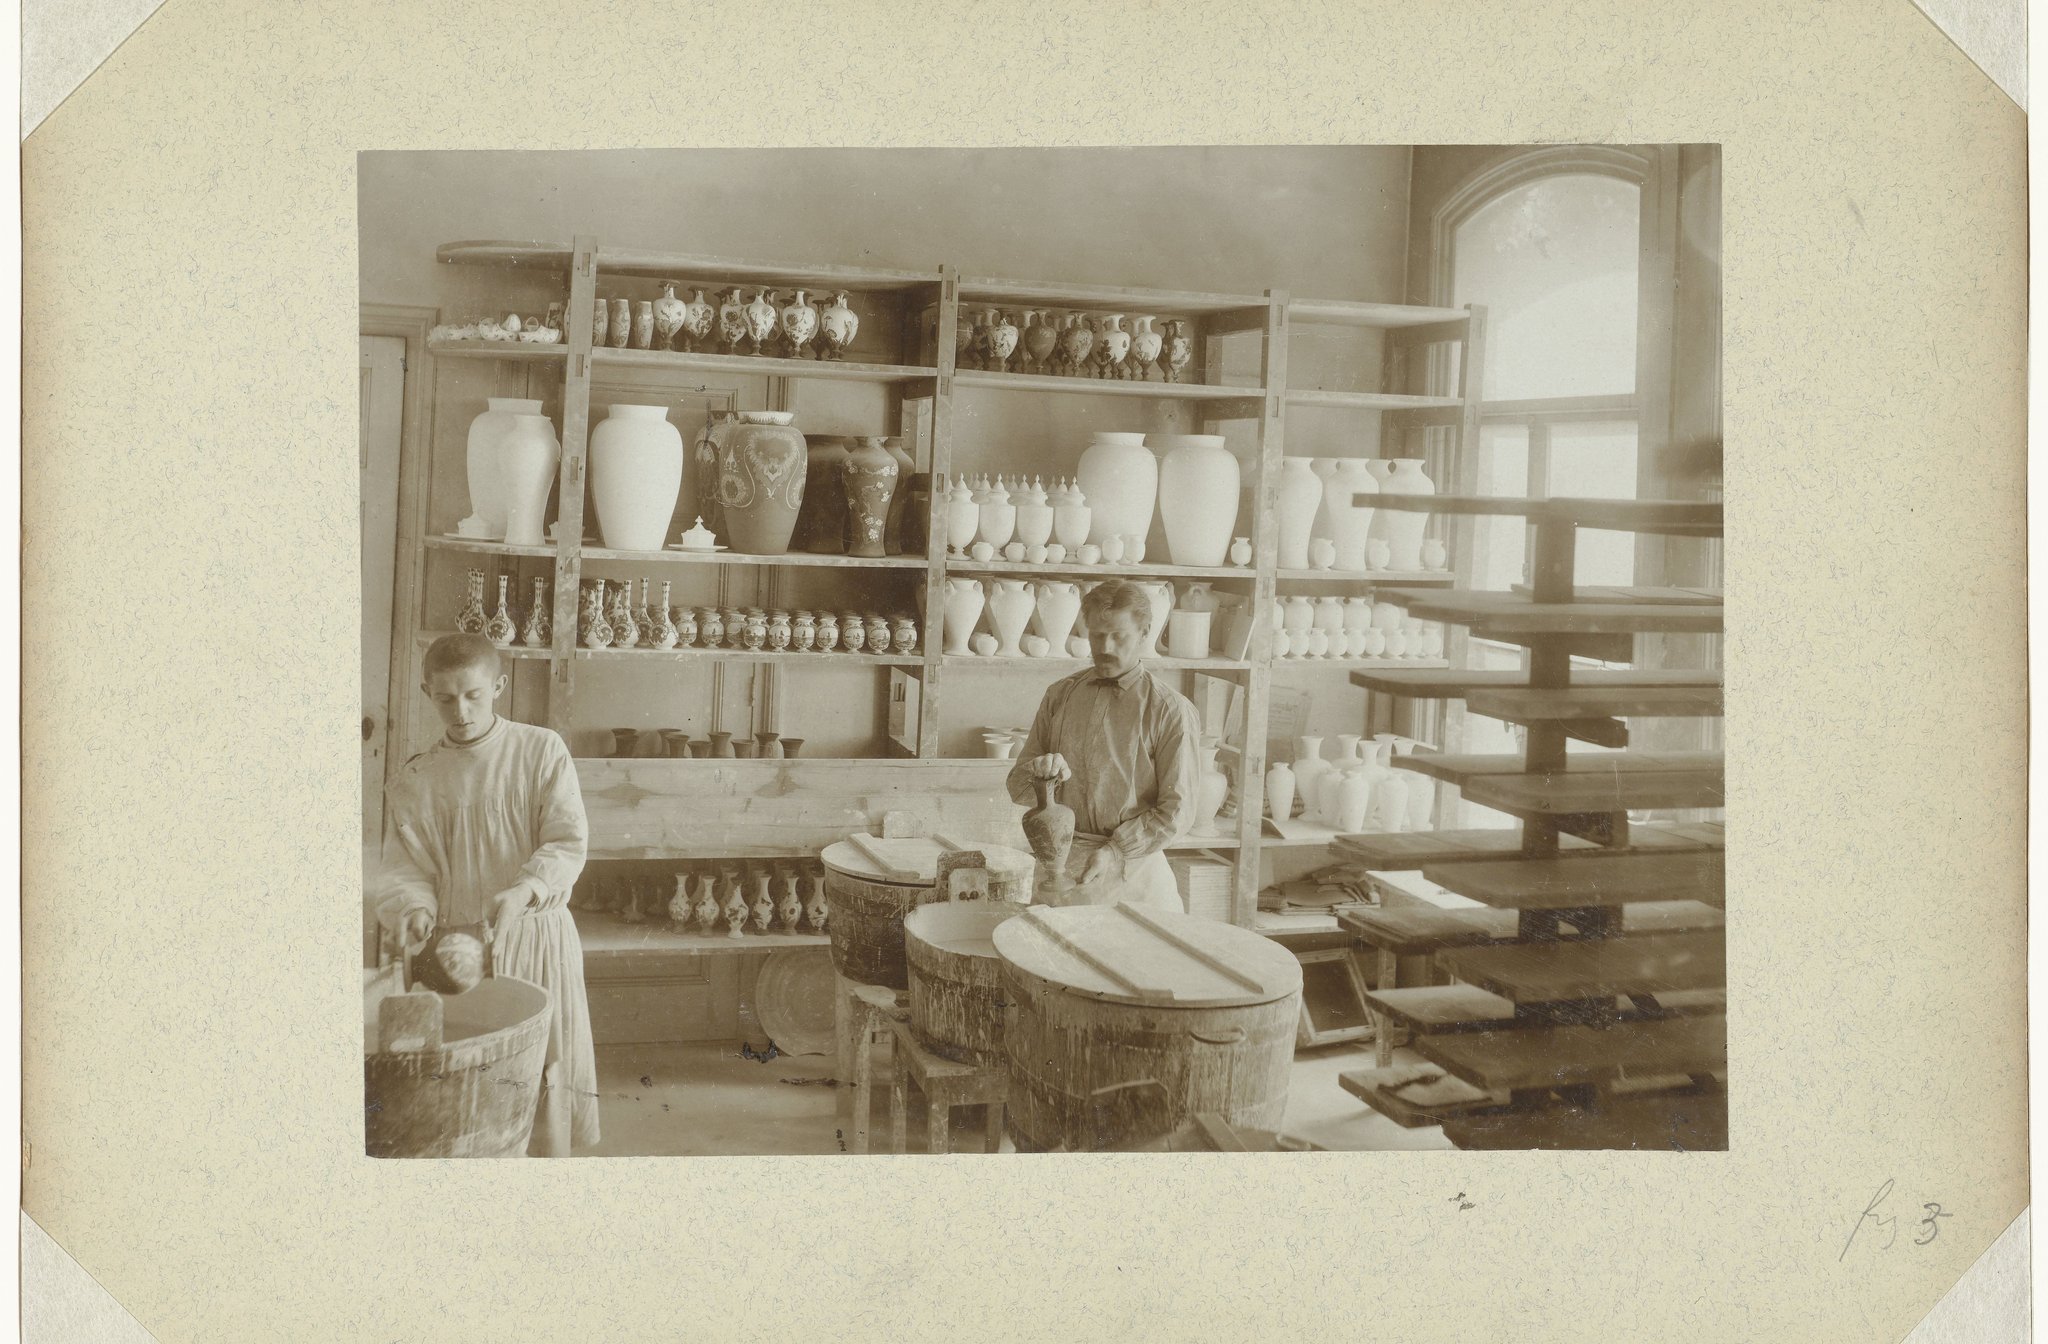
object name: photograph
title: Glazuurkamer van de porseleinfabriek Rozenburg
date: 1890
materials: cardboard, paper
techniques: collodion silver print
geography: the hague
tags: workshop-interior, the hague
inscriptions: stamp: ‘Ritscher & Landsman photografen Amsterdam’